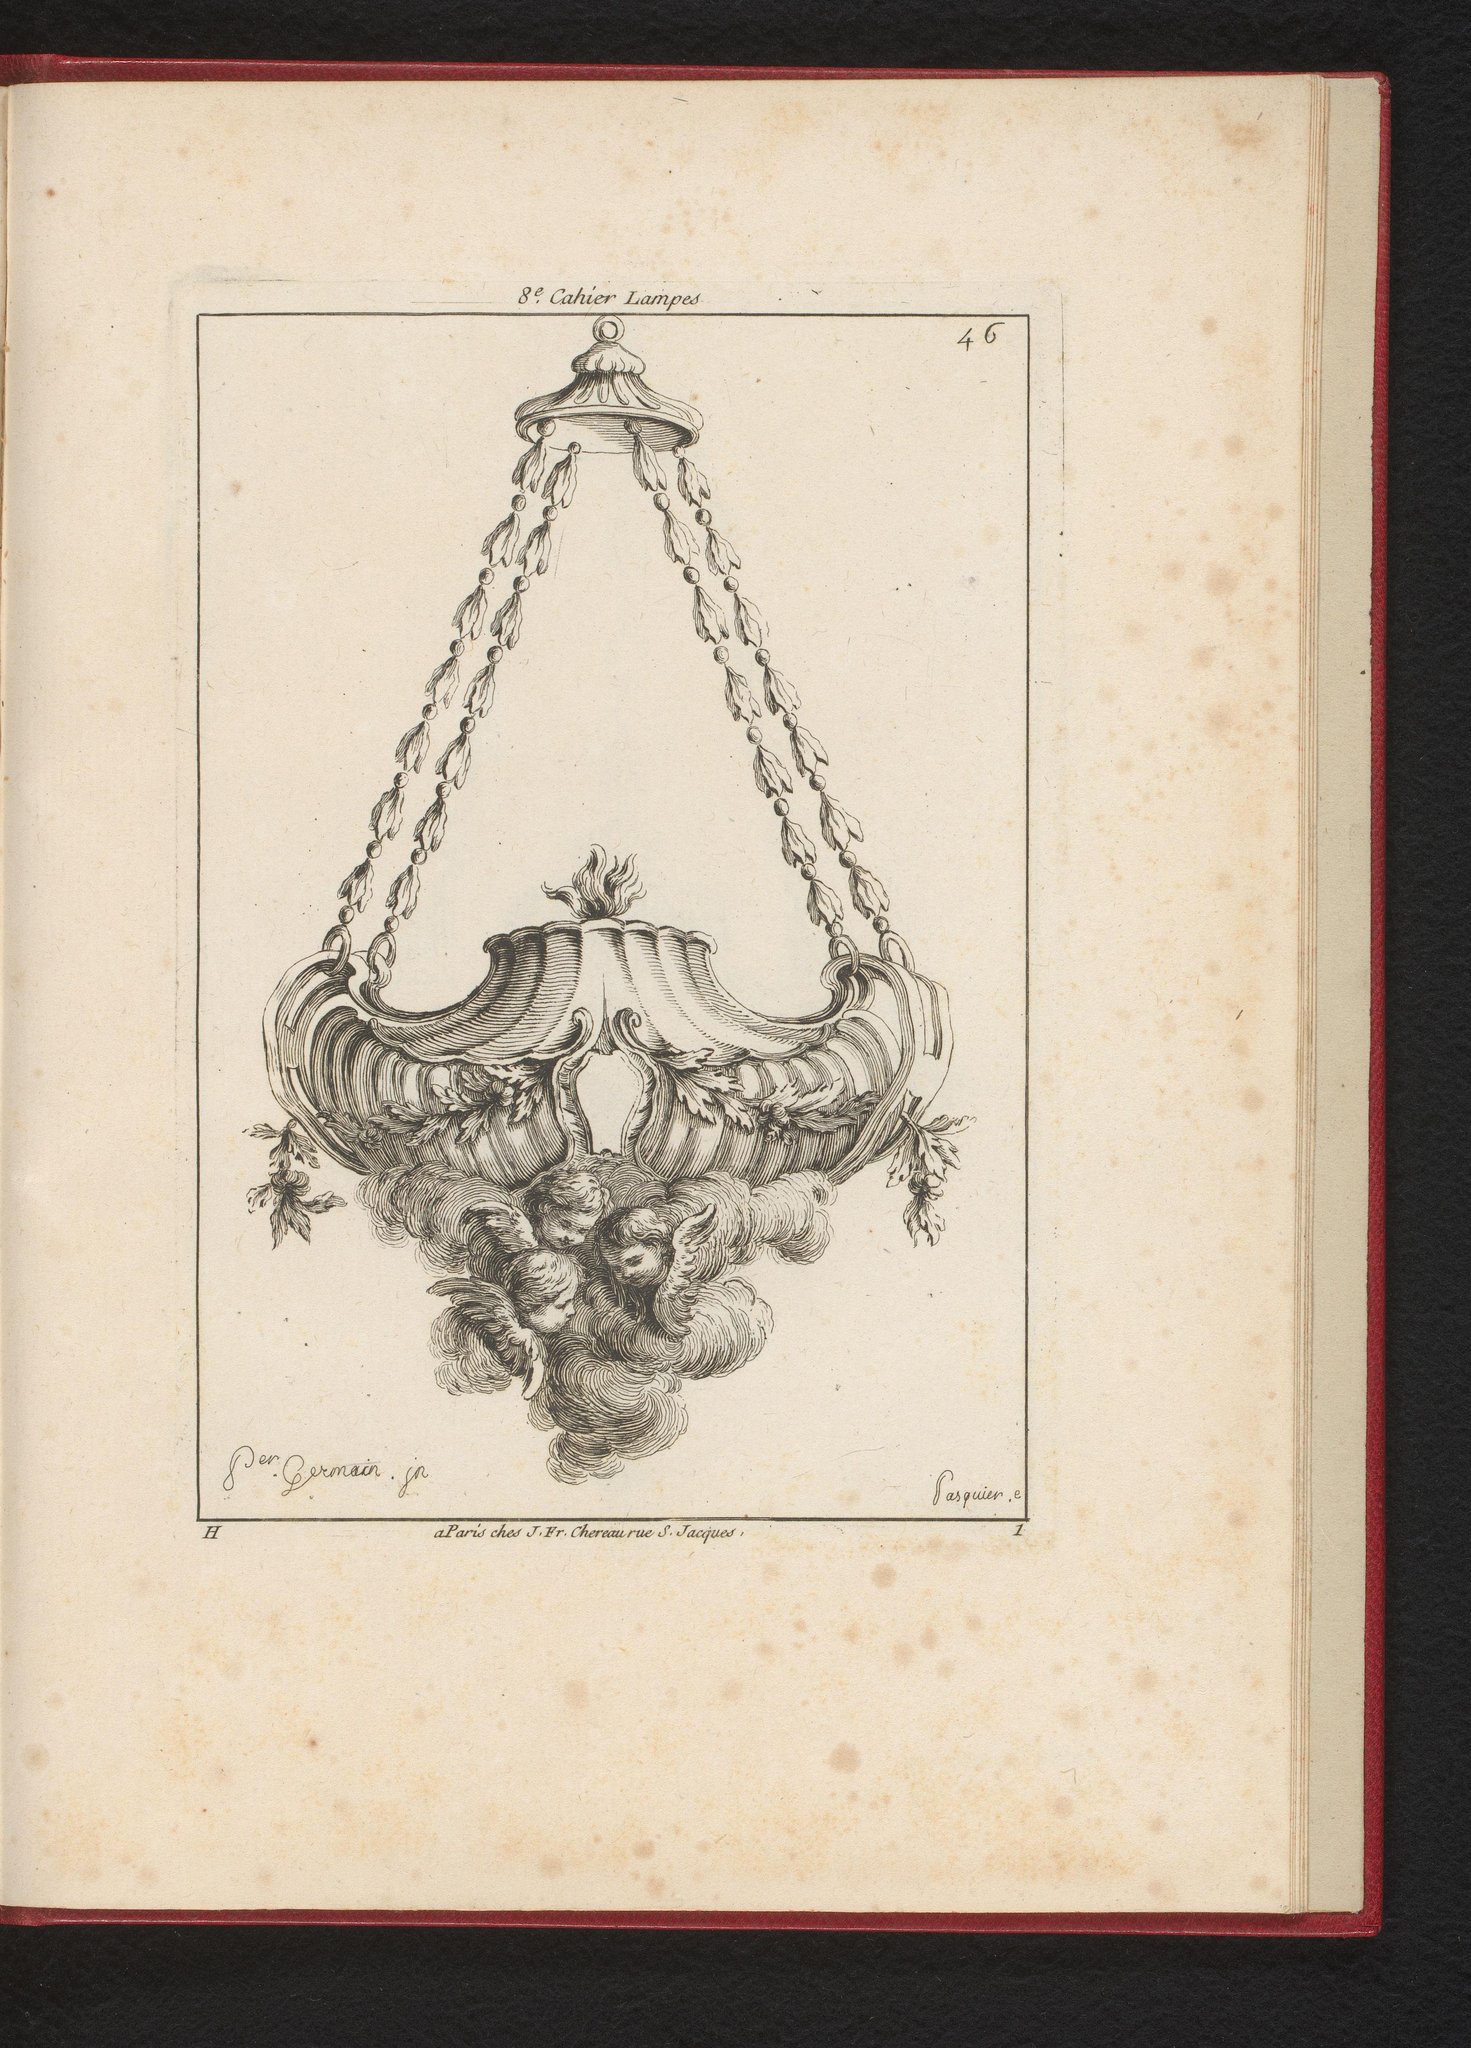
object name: print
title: Zilverwerk en edelsmeedkunst, eerste deel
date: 1748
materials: paper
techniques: etching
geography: paris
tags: altarlamp, altar fire, jeweller, goldsmith, silversmith, oil-lamp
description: Deze prent maakt deel uit van een album.